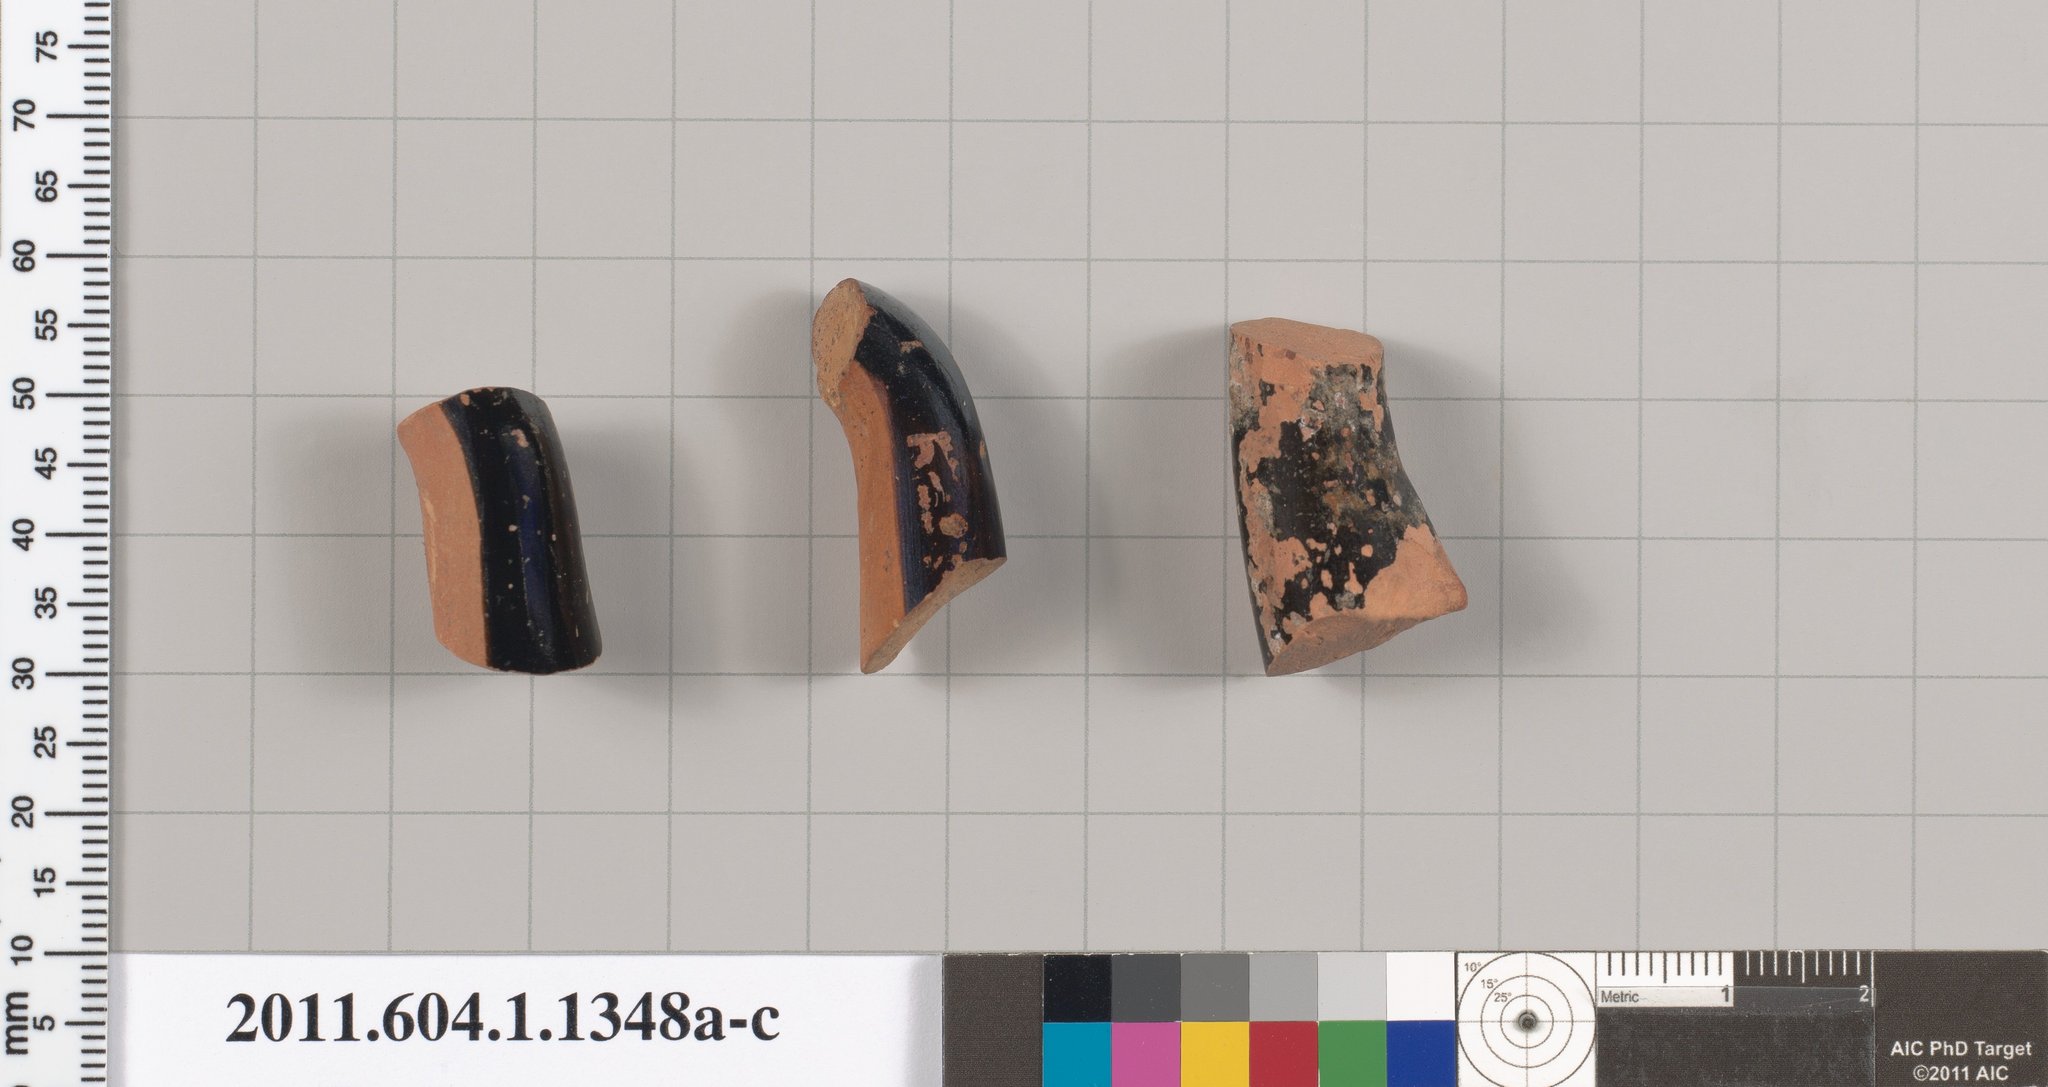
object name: kylix fragment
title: Terracotta fragments of kylikes (drinking cups)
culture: greek, attic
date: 500-401 BCE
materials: terracotta